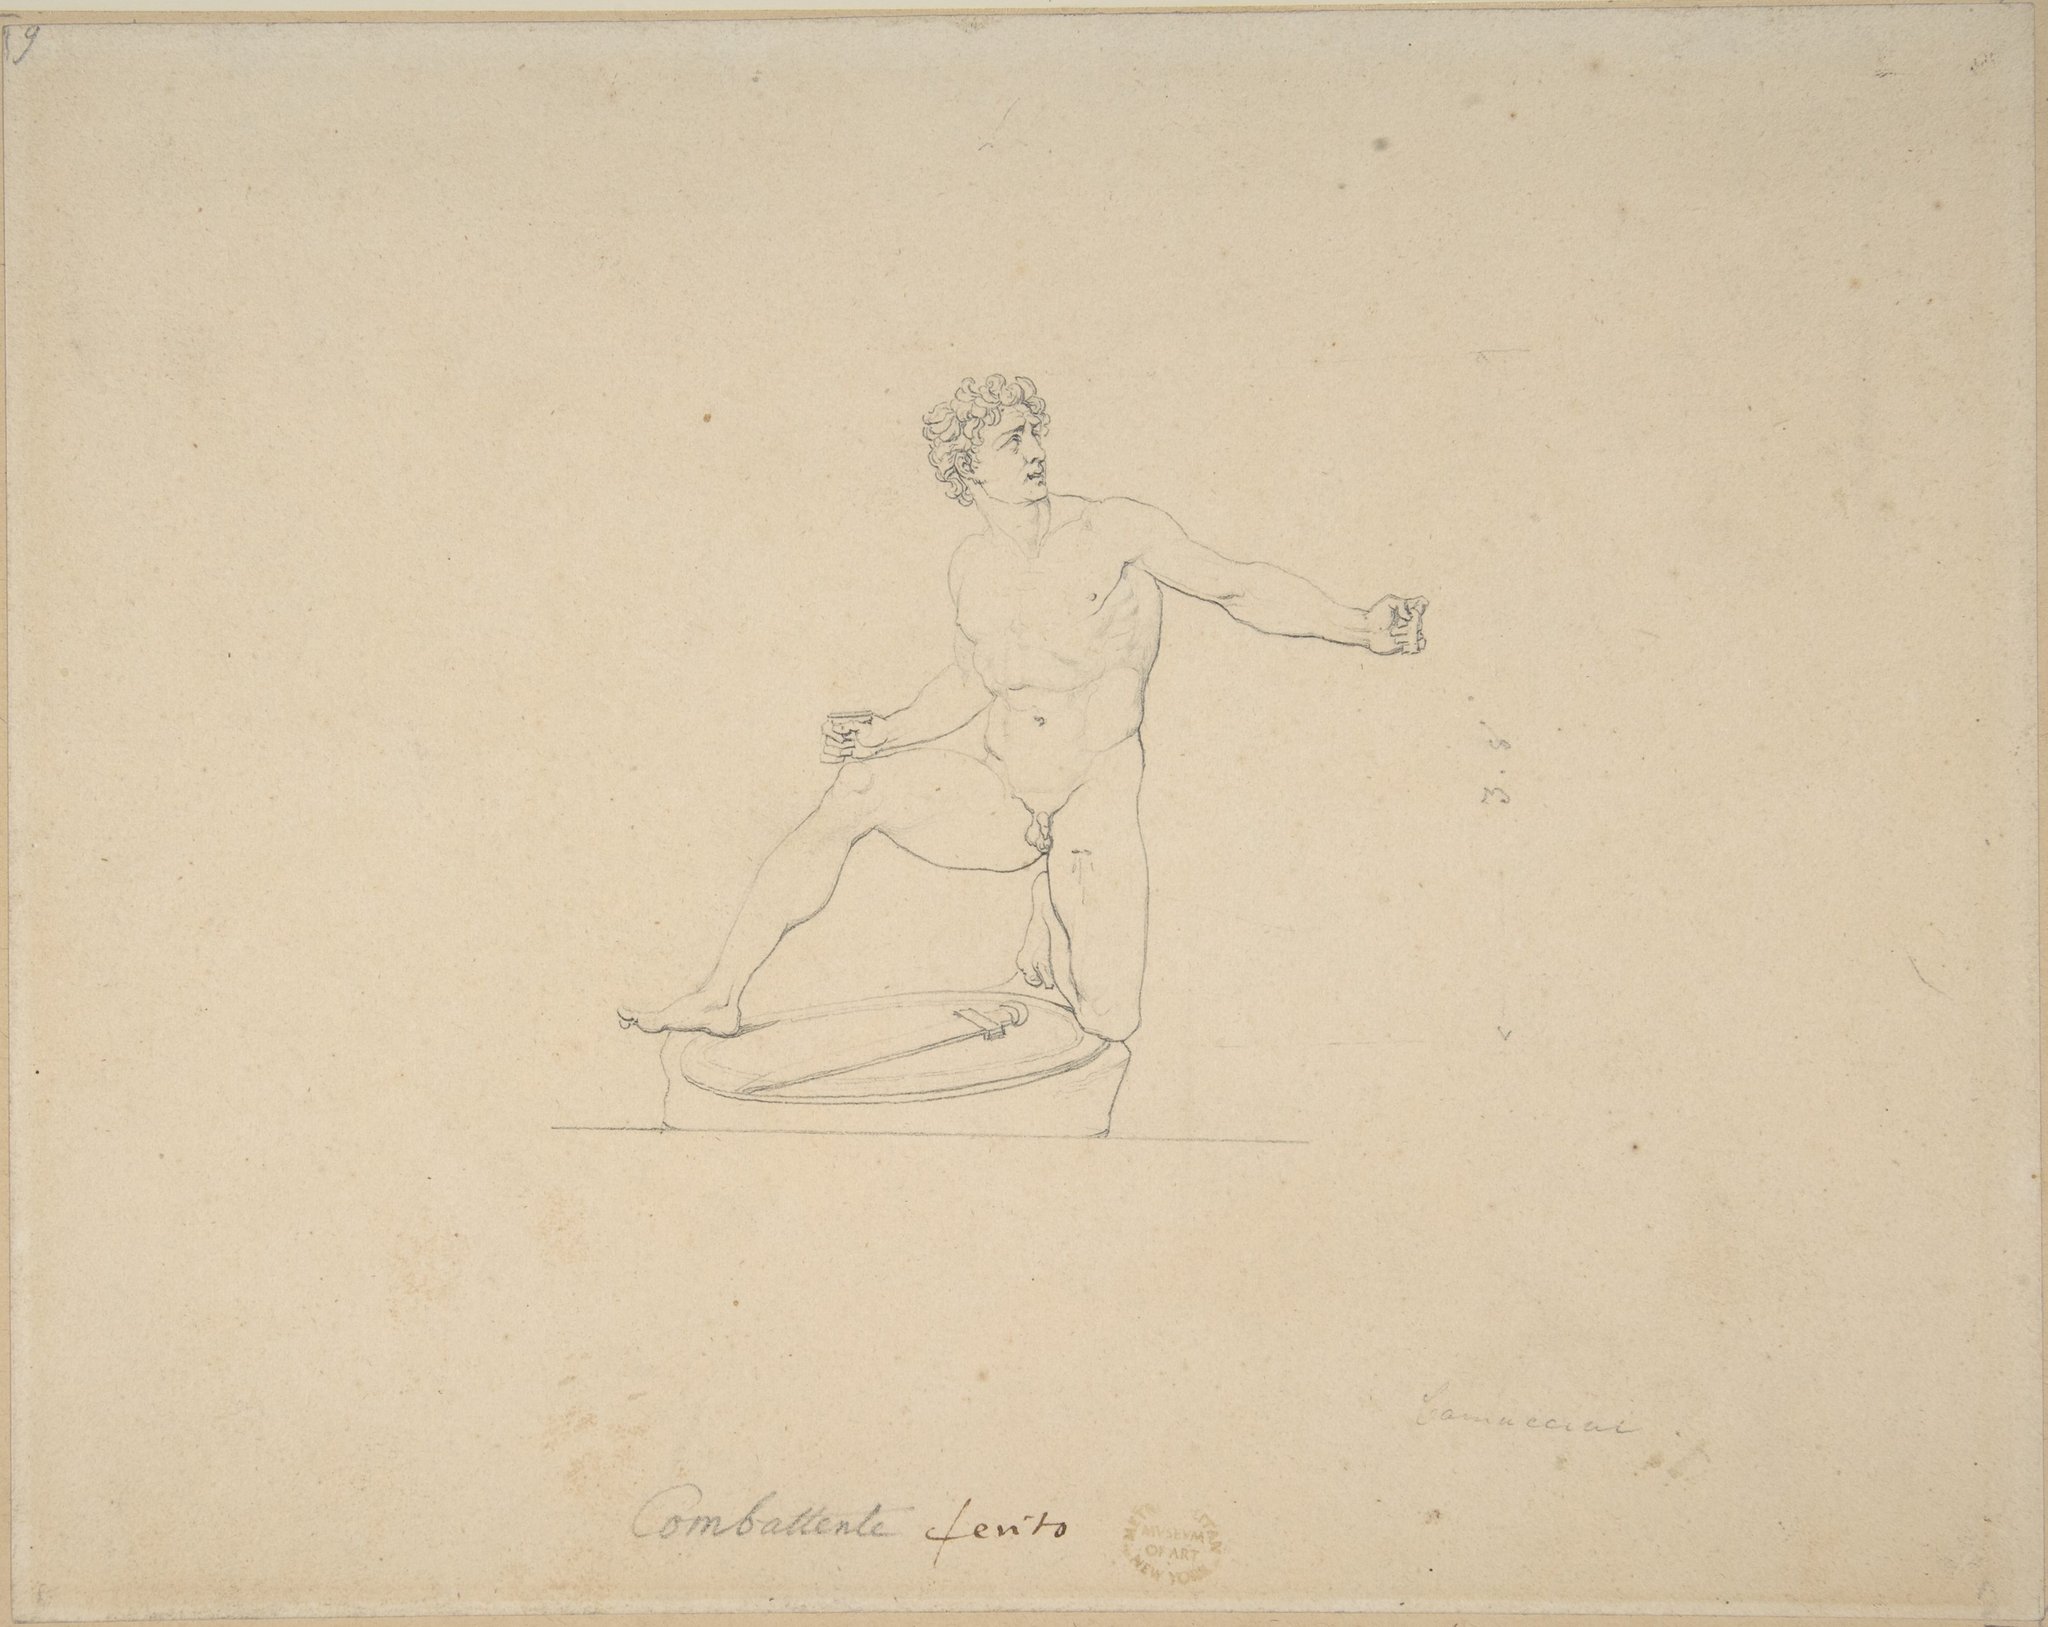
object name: drawing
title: Kneeling Gladiator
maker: vincenzo camuccini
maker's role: artist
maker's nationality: italian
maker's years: 1771-1844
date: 1795-1844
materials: graphite, lead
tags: male nudes